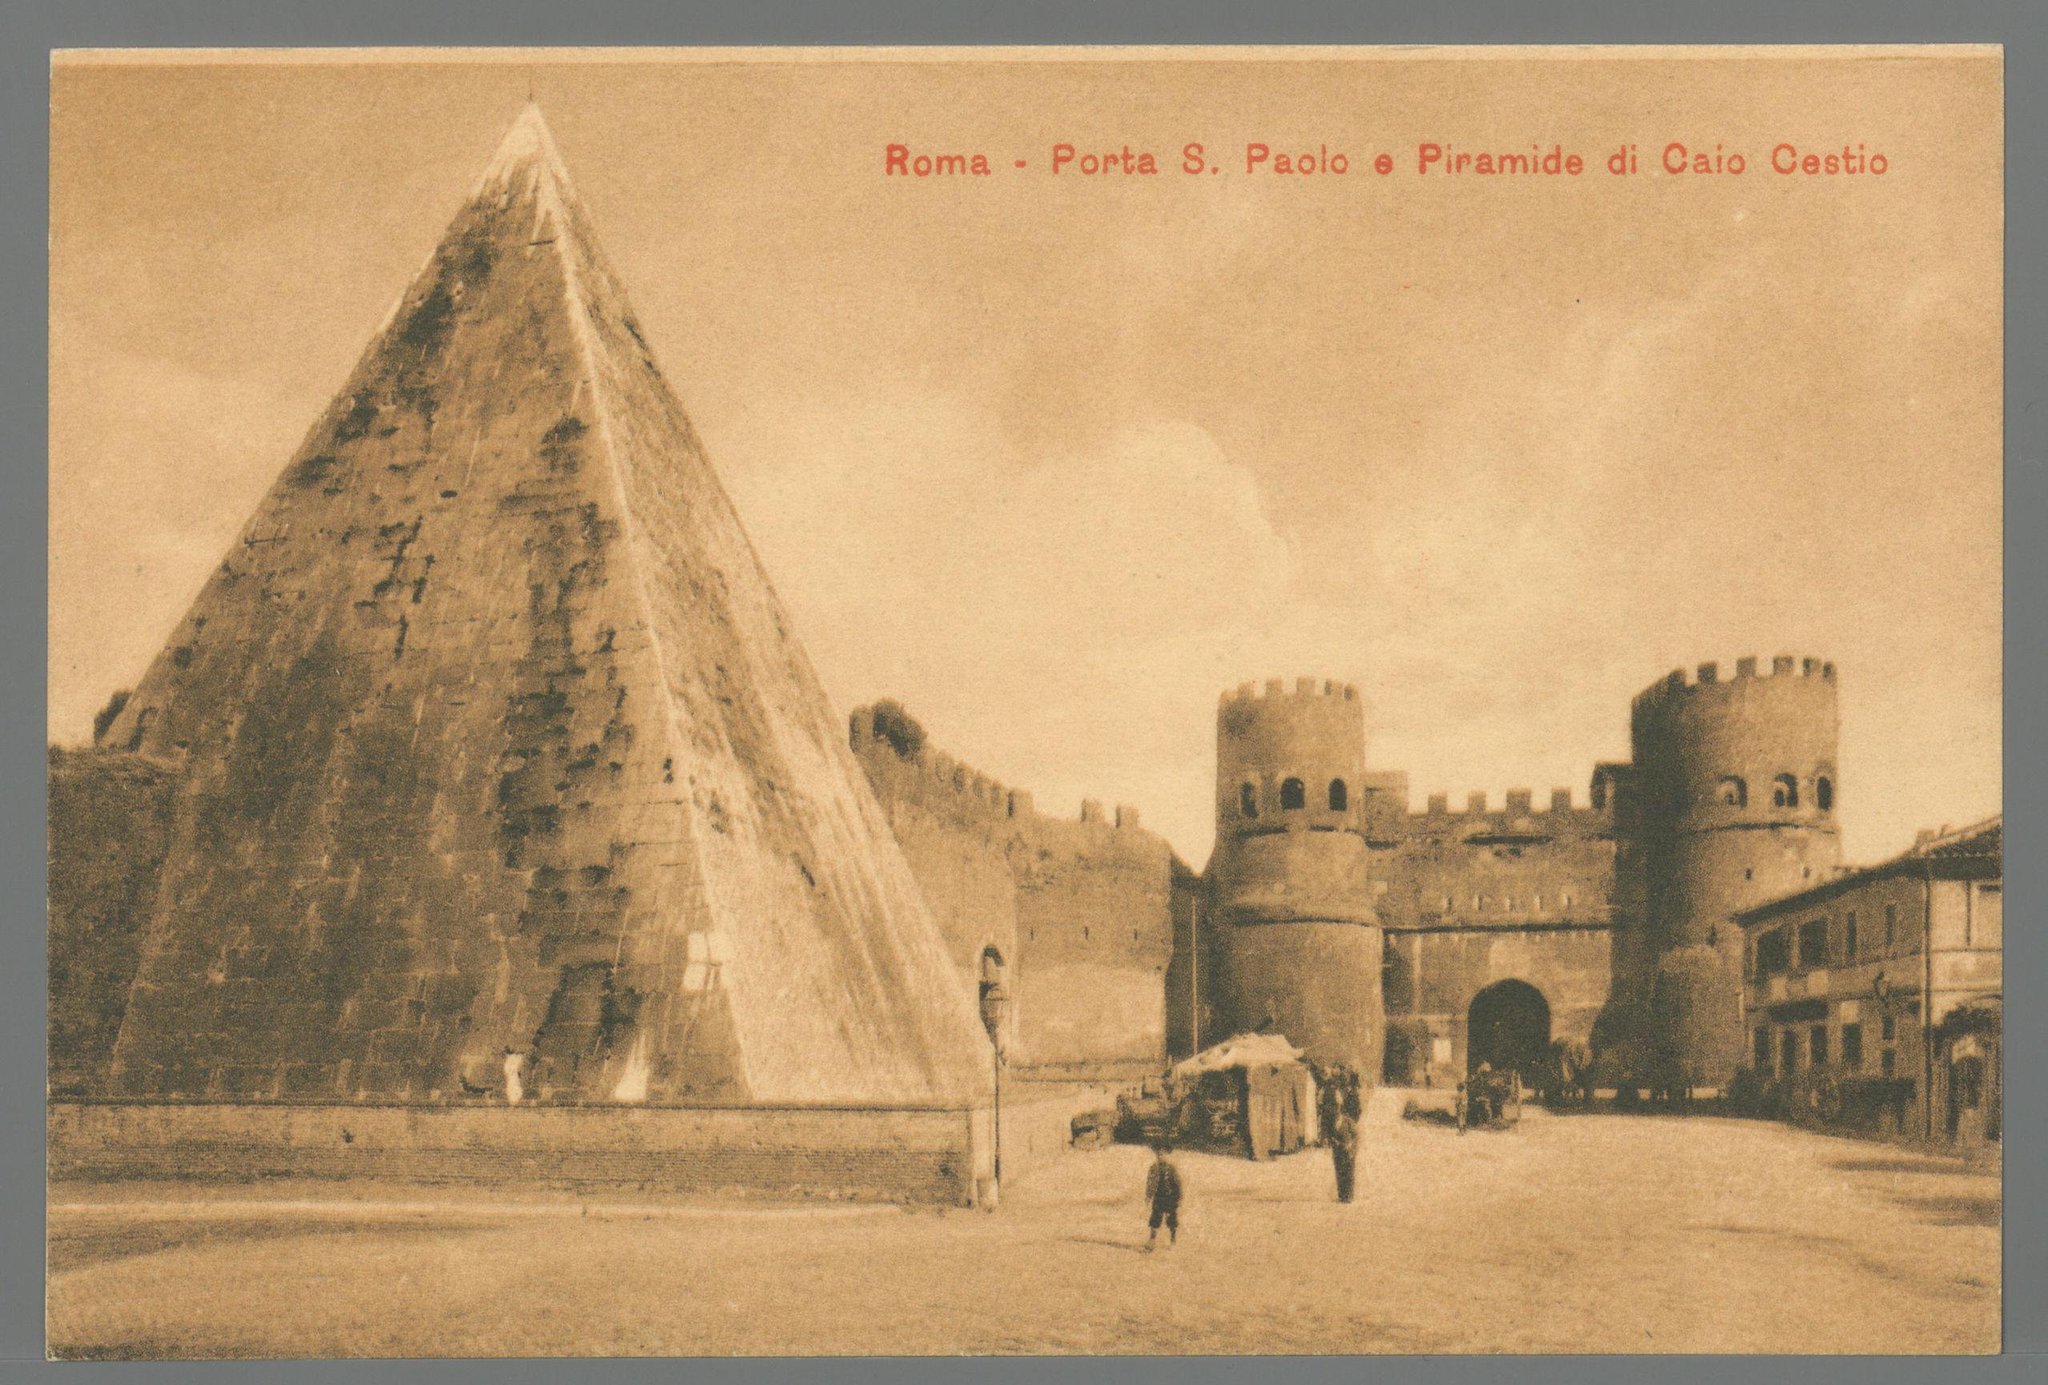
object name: ansichtkaart, prentbriefkaart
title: Roma. Porta S. Paolo e Piramide di Caio Cestio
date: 1906-1920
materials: cardboard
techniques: photograph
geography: rome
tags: pyramid (historical grave form), city-gate, square, place, circus, etc. (+ city(-scape) with figures, staffage)